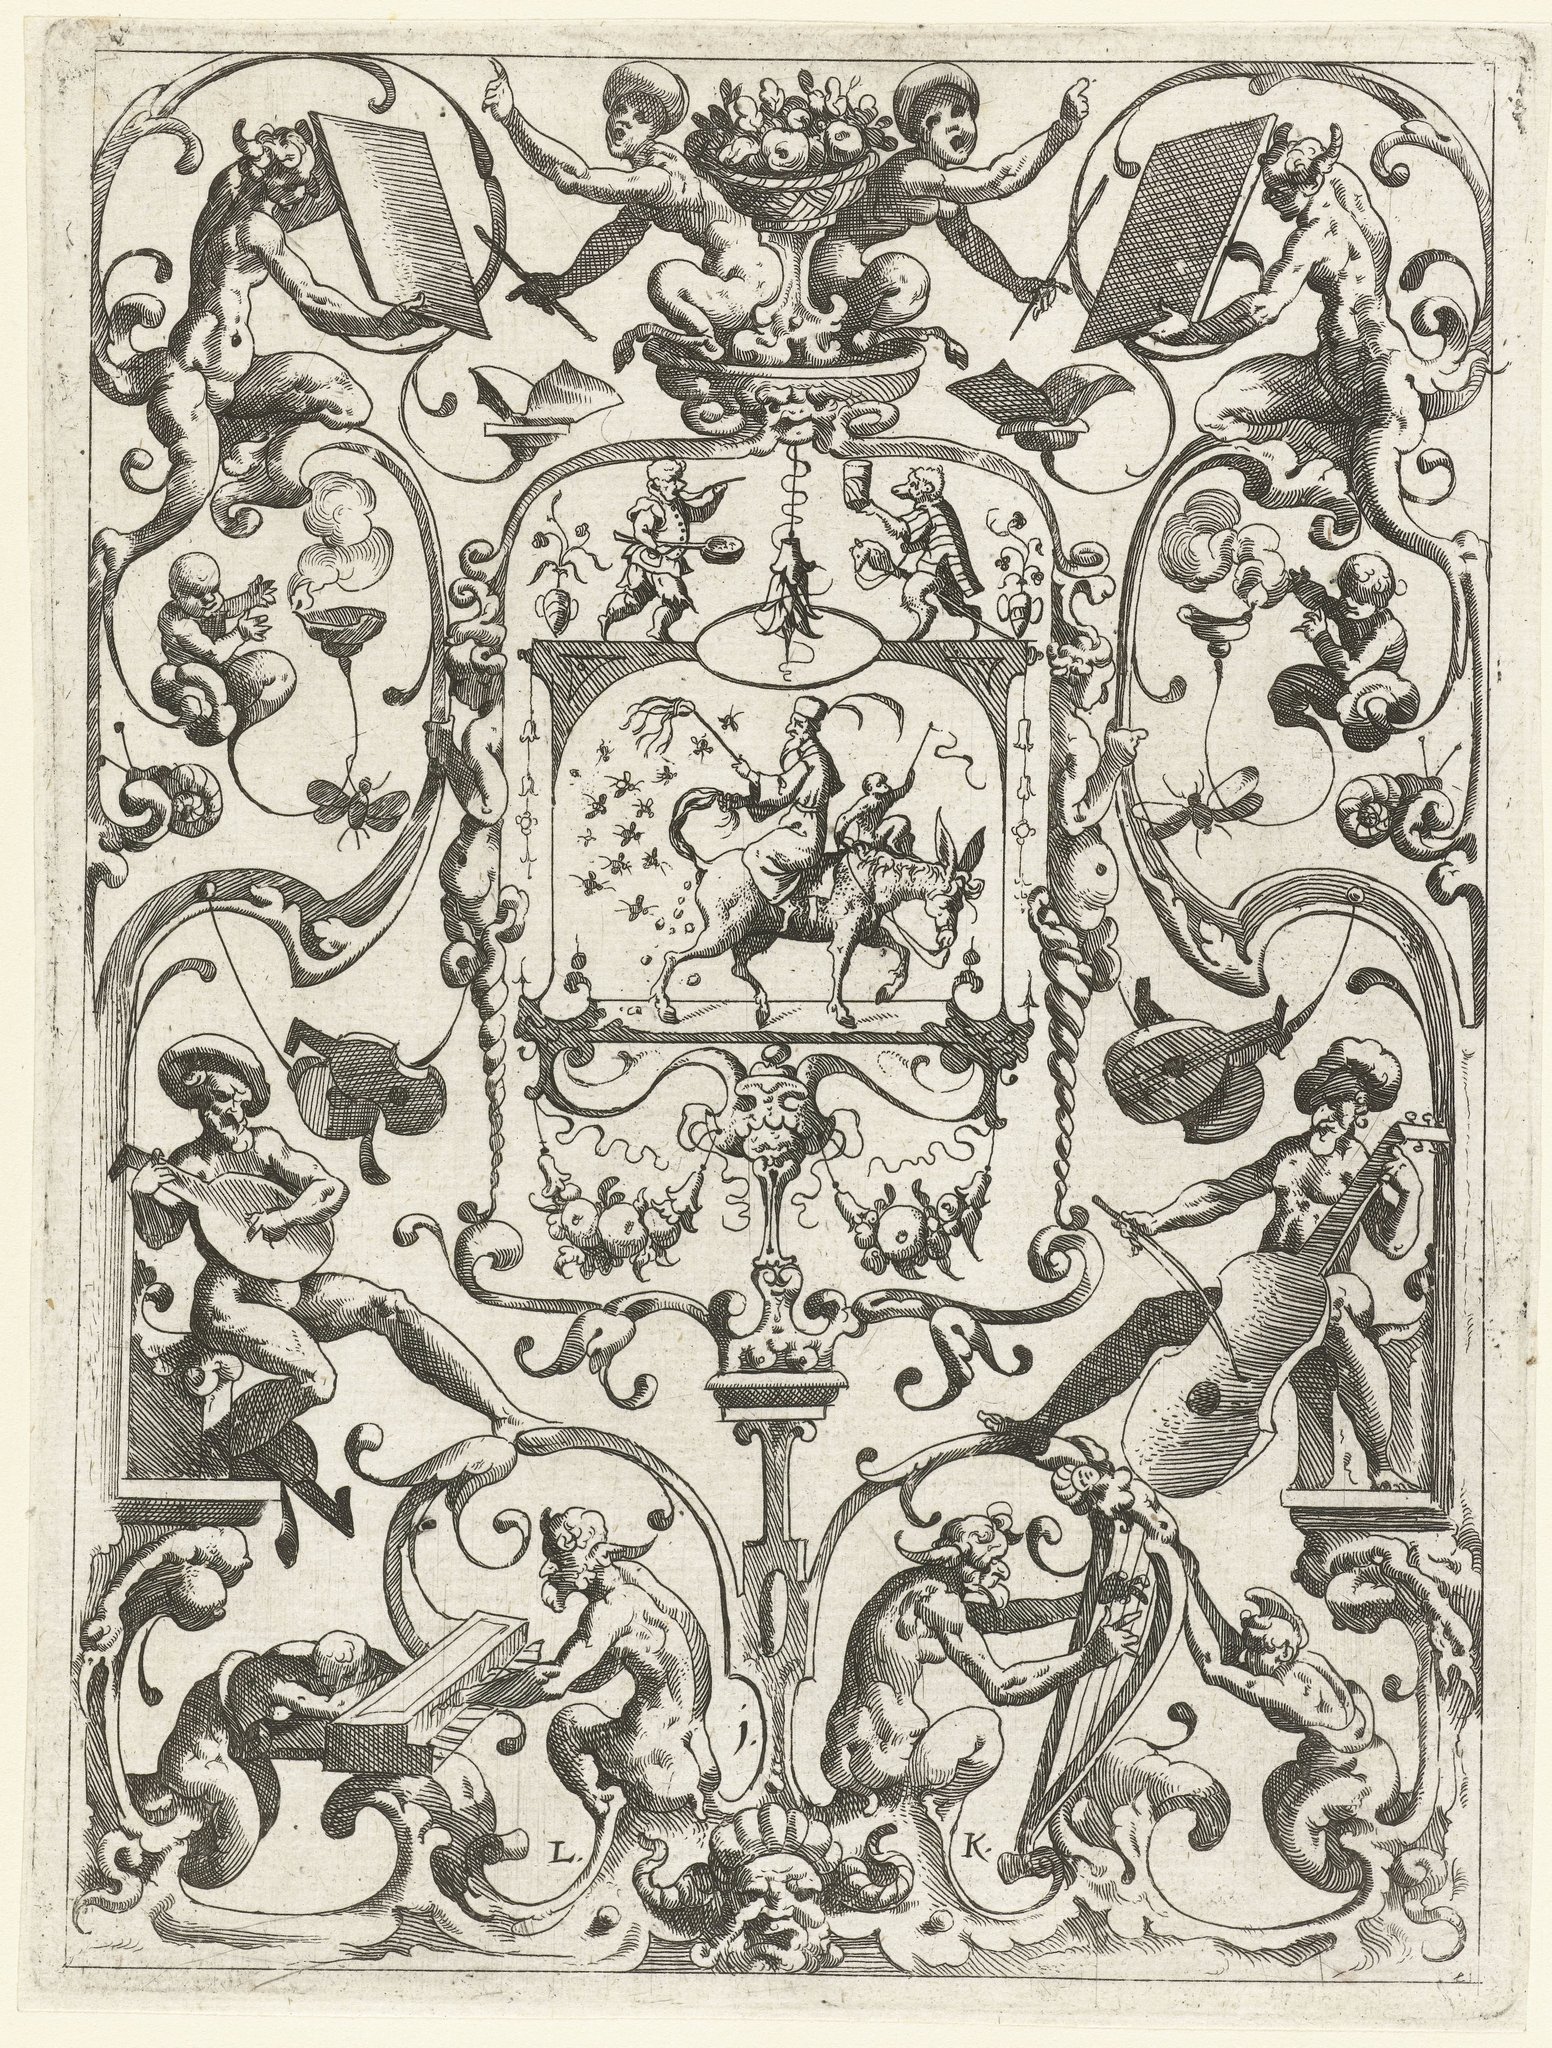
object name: print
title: Newes Gradesca Büchlein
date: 1607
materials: paper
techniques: etching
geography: augsburg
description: In het midden zit een man in oosterse kleding achterstevoren op een ezel. Blad 1 uit serie met groteske vlakdecoraties met kwabornamenten.